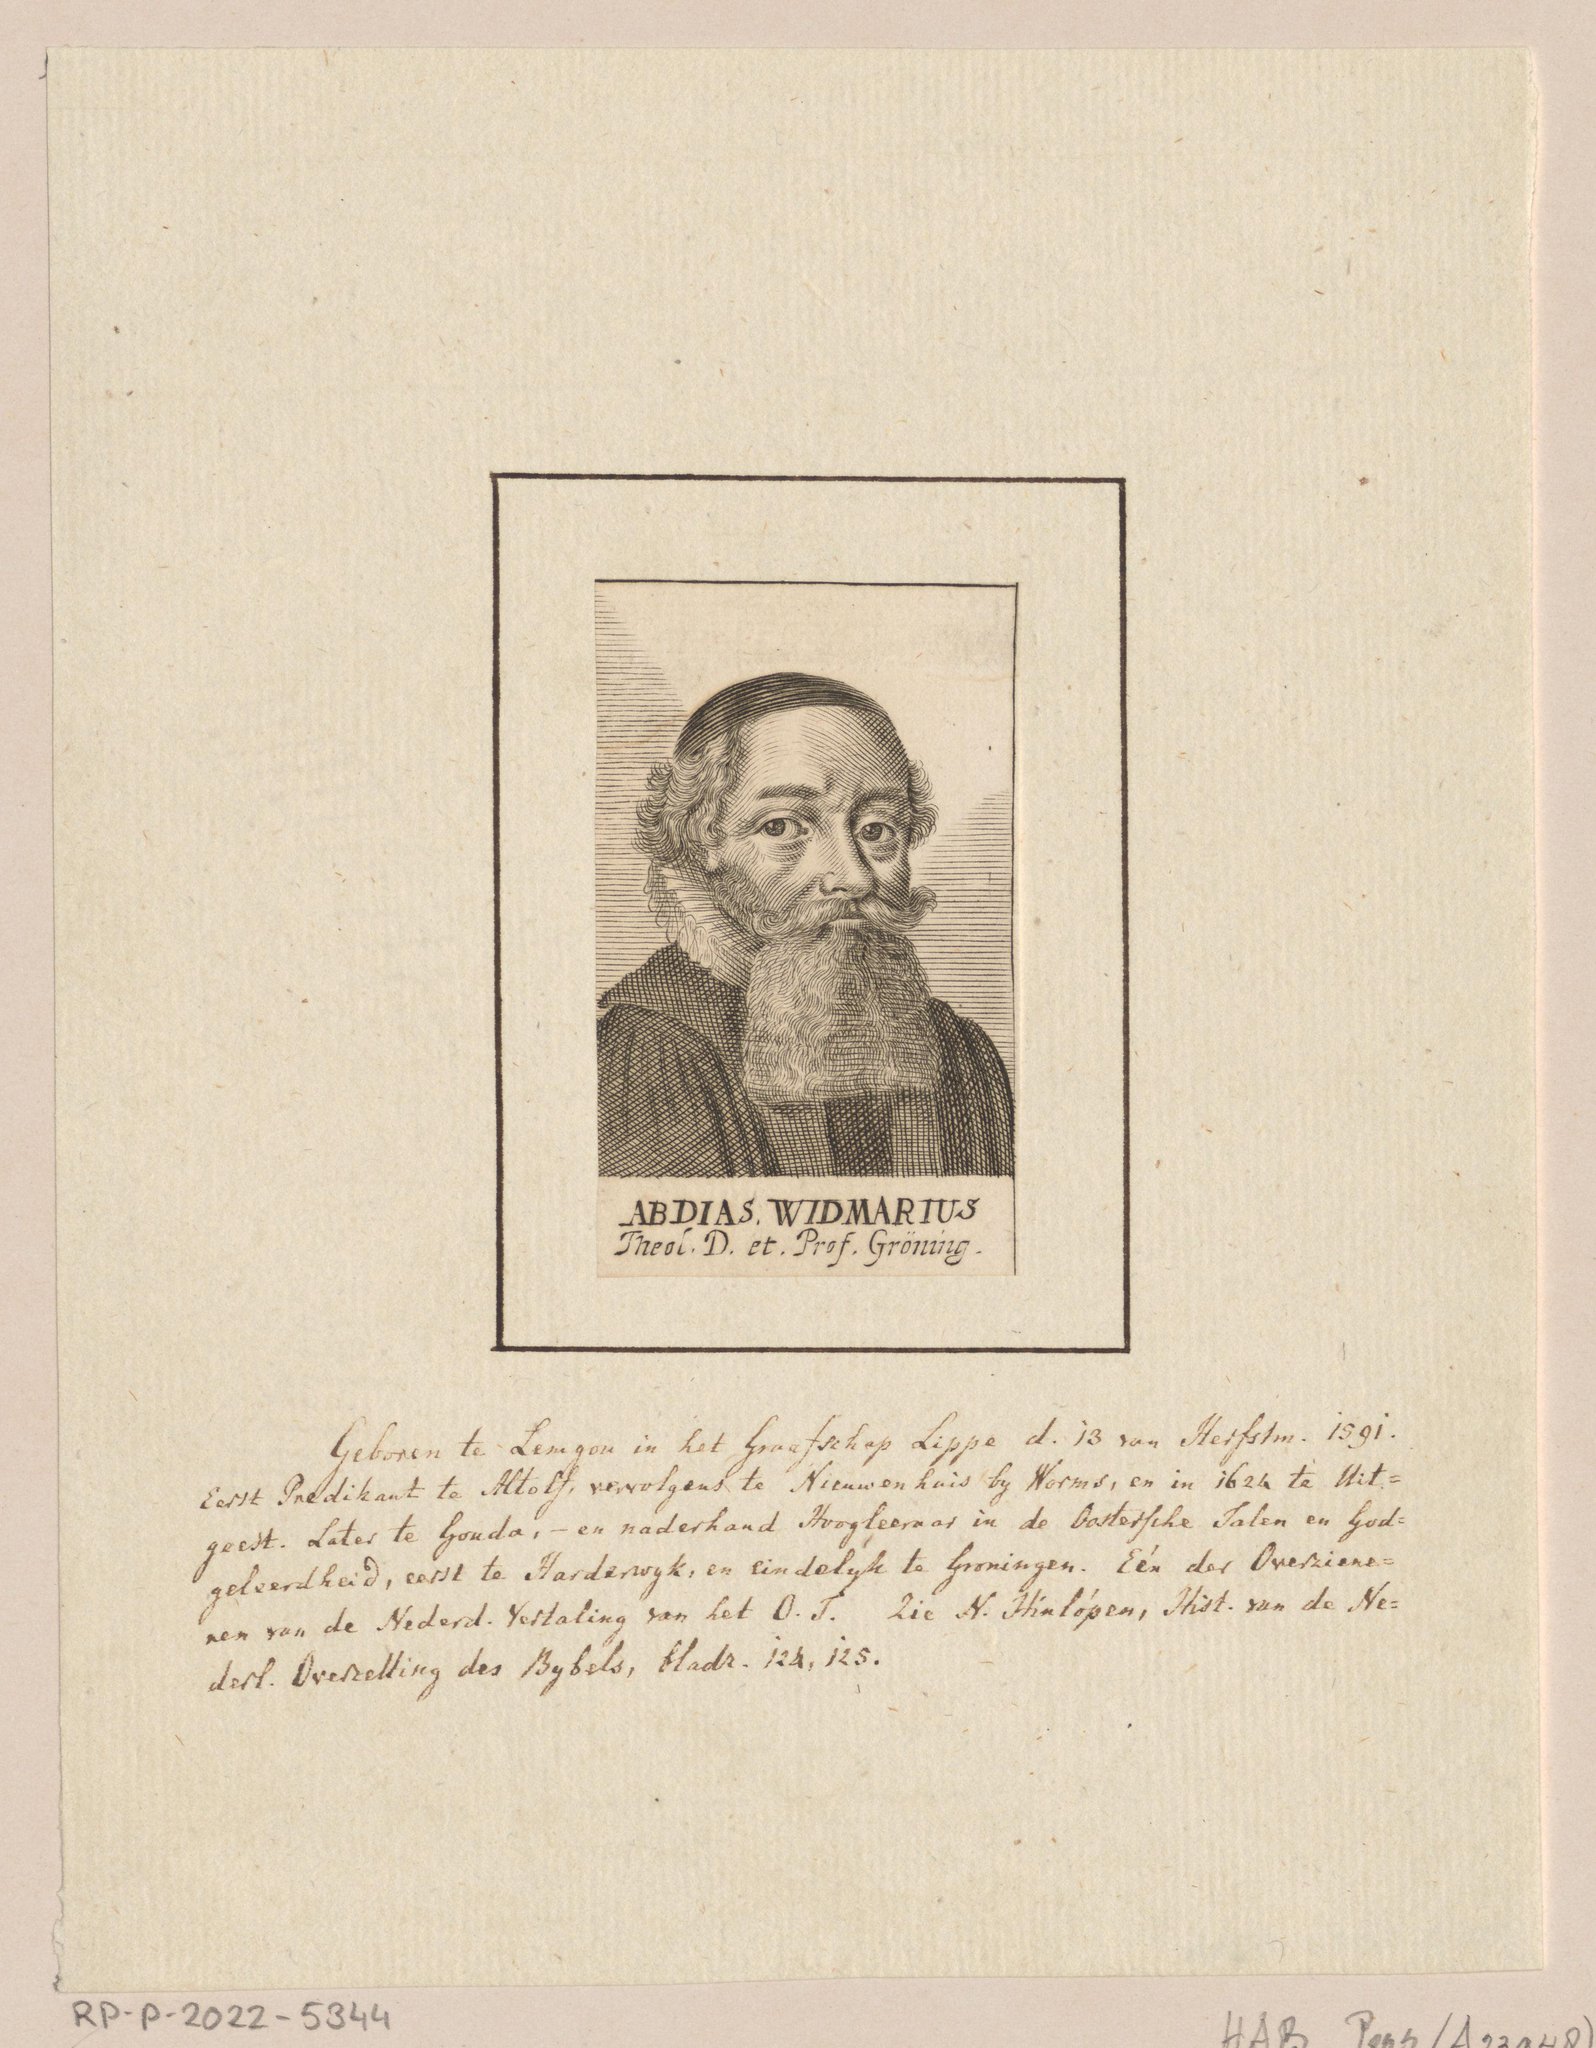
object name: print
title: Portret van Abdias Widmarius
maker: Anonymous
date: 1688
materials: paper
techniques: engraving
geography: germany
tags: theologian, historical persons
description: Prent uit: Freher, Paul. Theatrum virorum eruditione clarorum. Neurenberg: Johann Hoffmann, 1688.